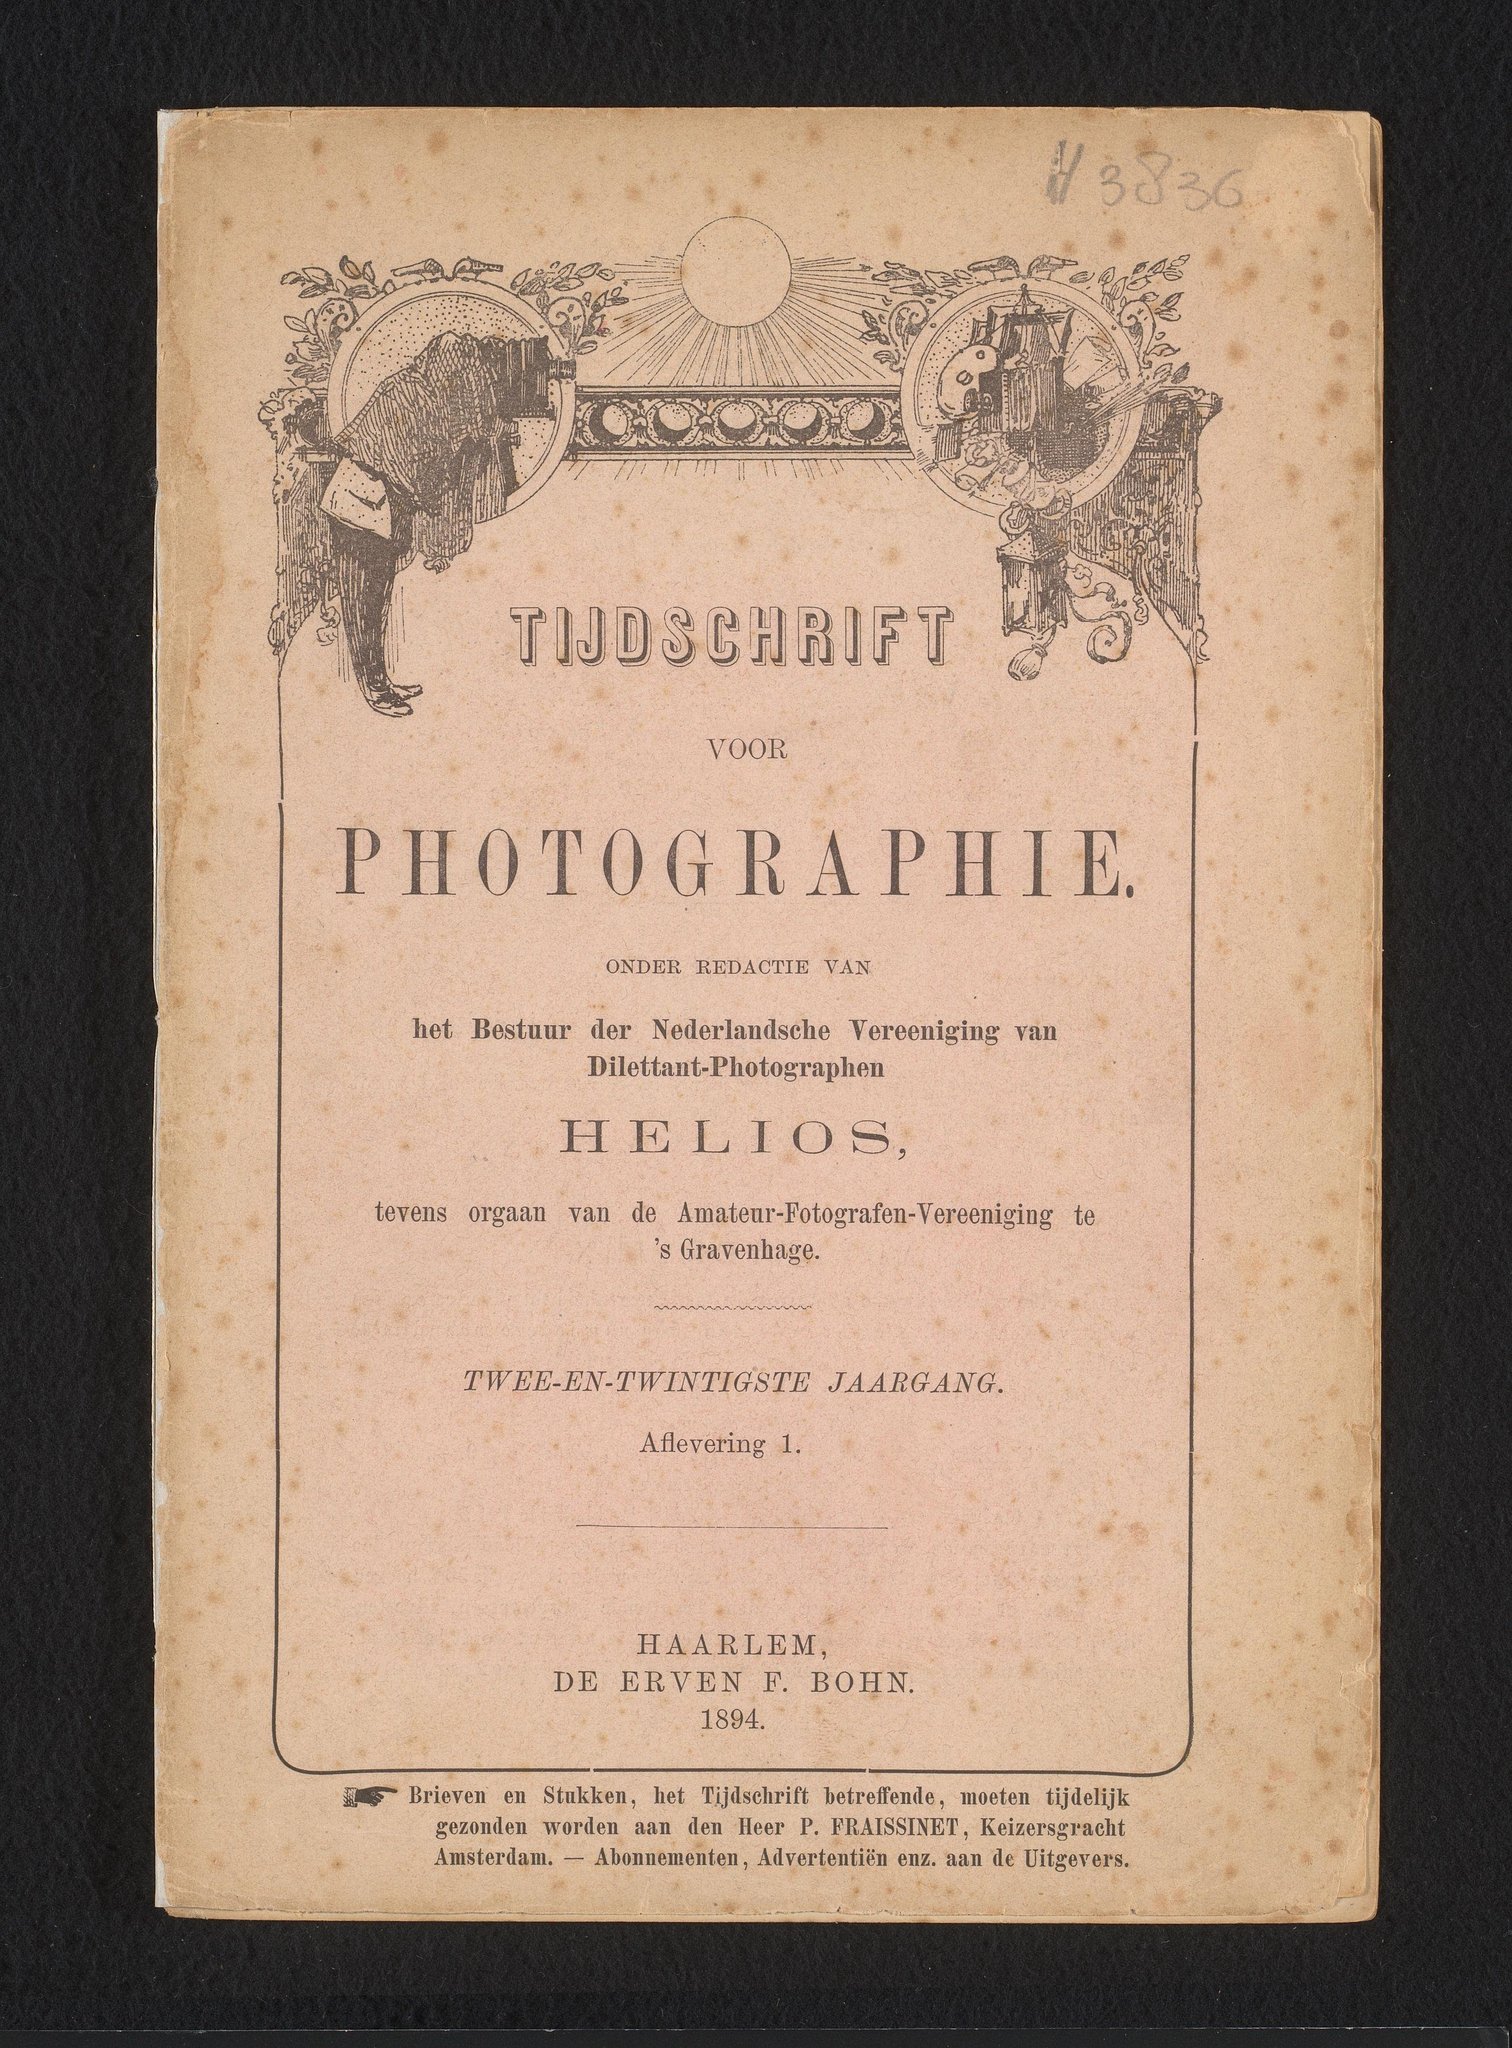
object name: magazine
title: Tijdschrift voor photographie / Helios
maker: erven françois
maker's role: uitgeverij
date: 1894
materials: cardboard, paper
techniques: photograph, printing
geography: haarlem